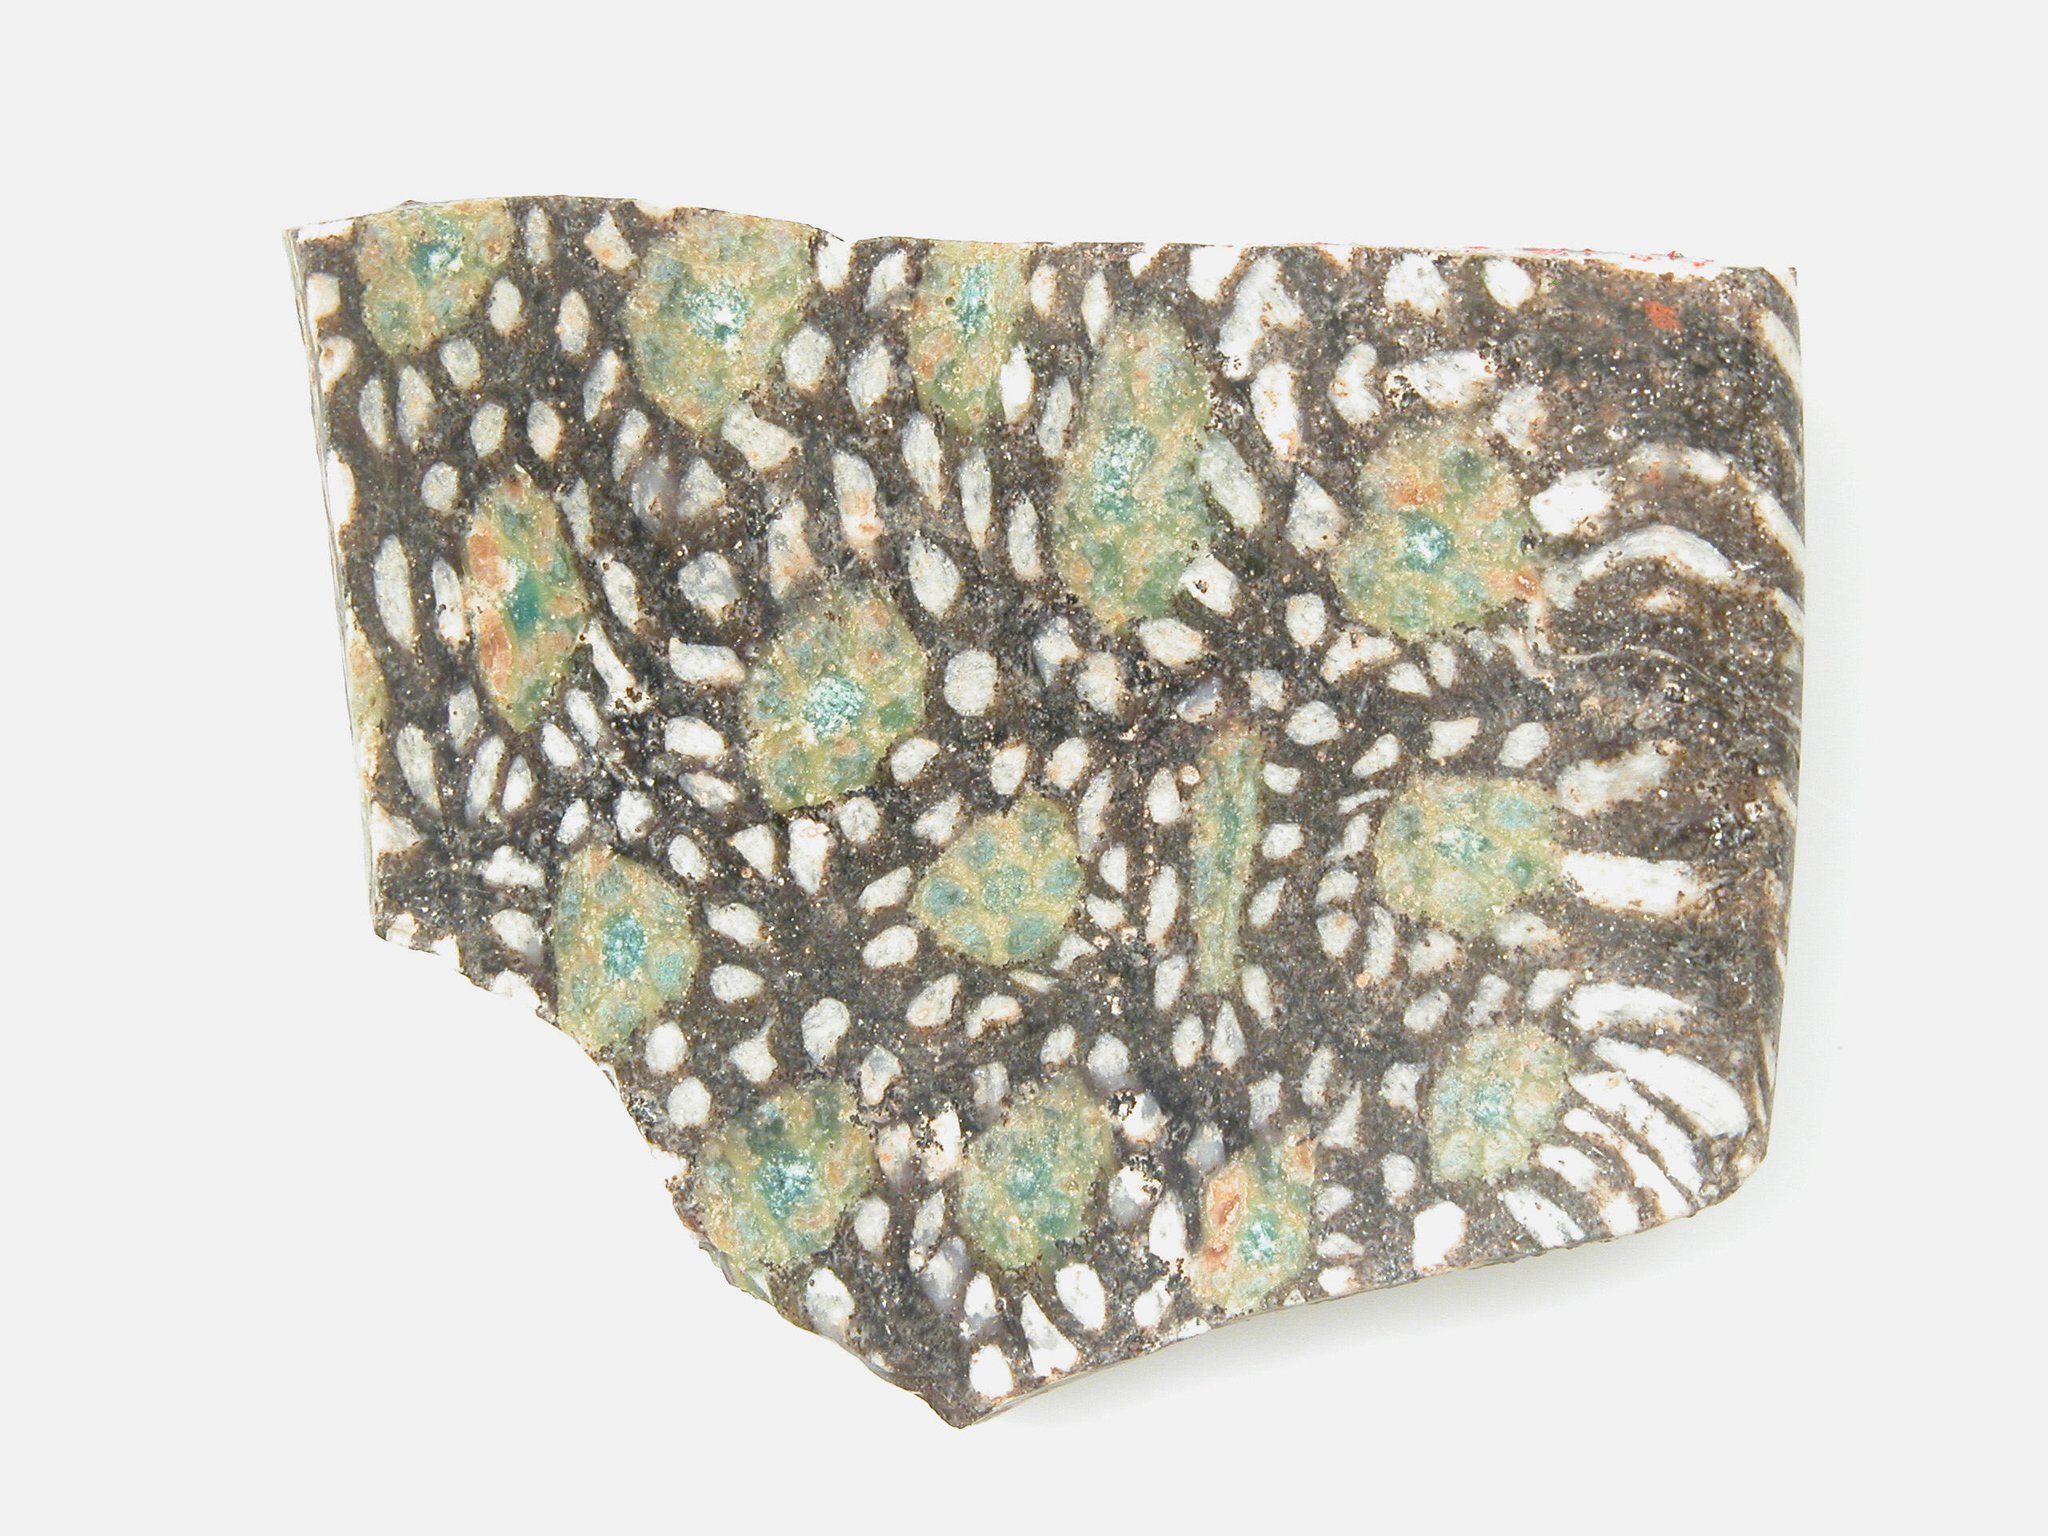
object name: fragment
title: Glass Fragment from a Vessel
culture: coptic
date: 301-433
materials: glass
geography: egypt